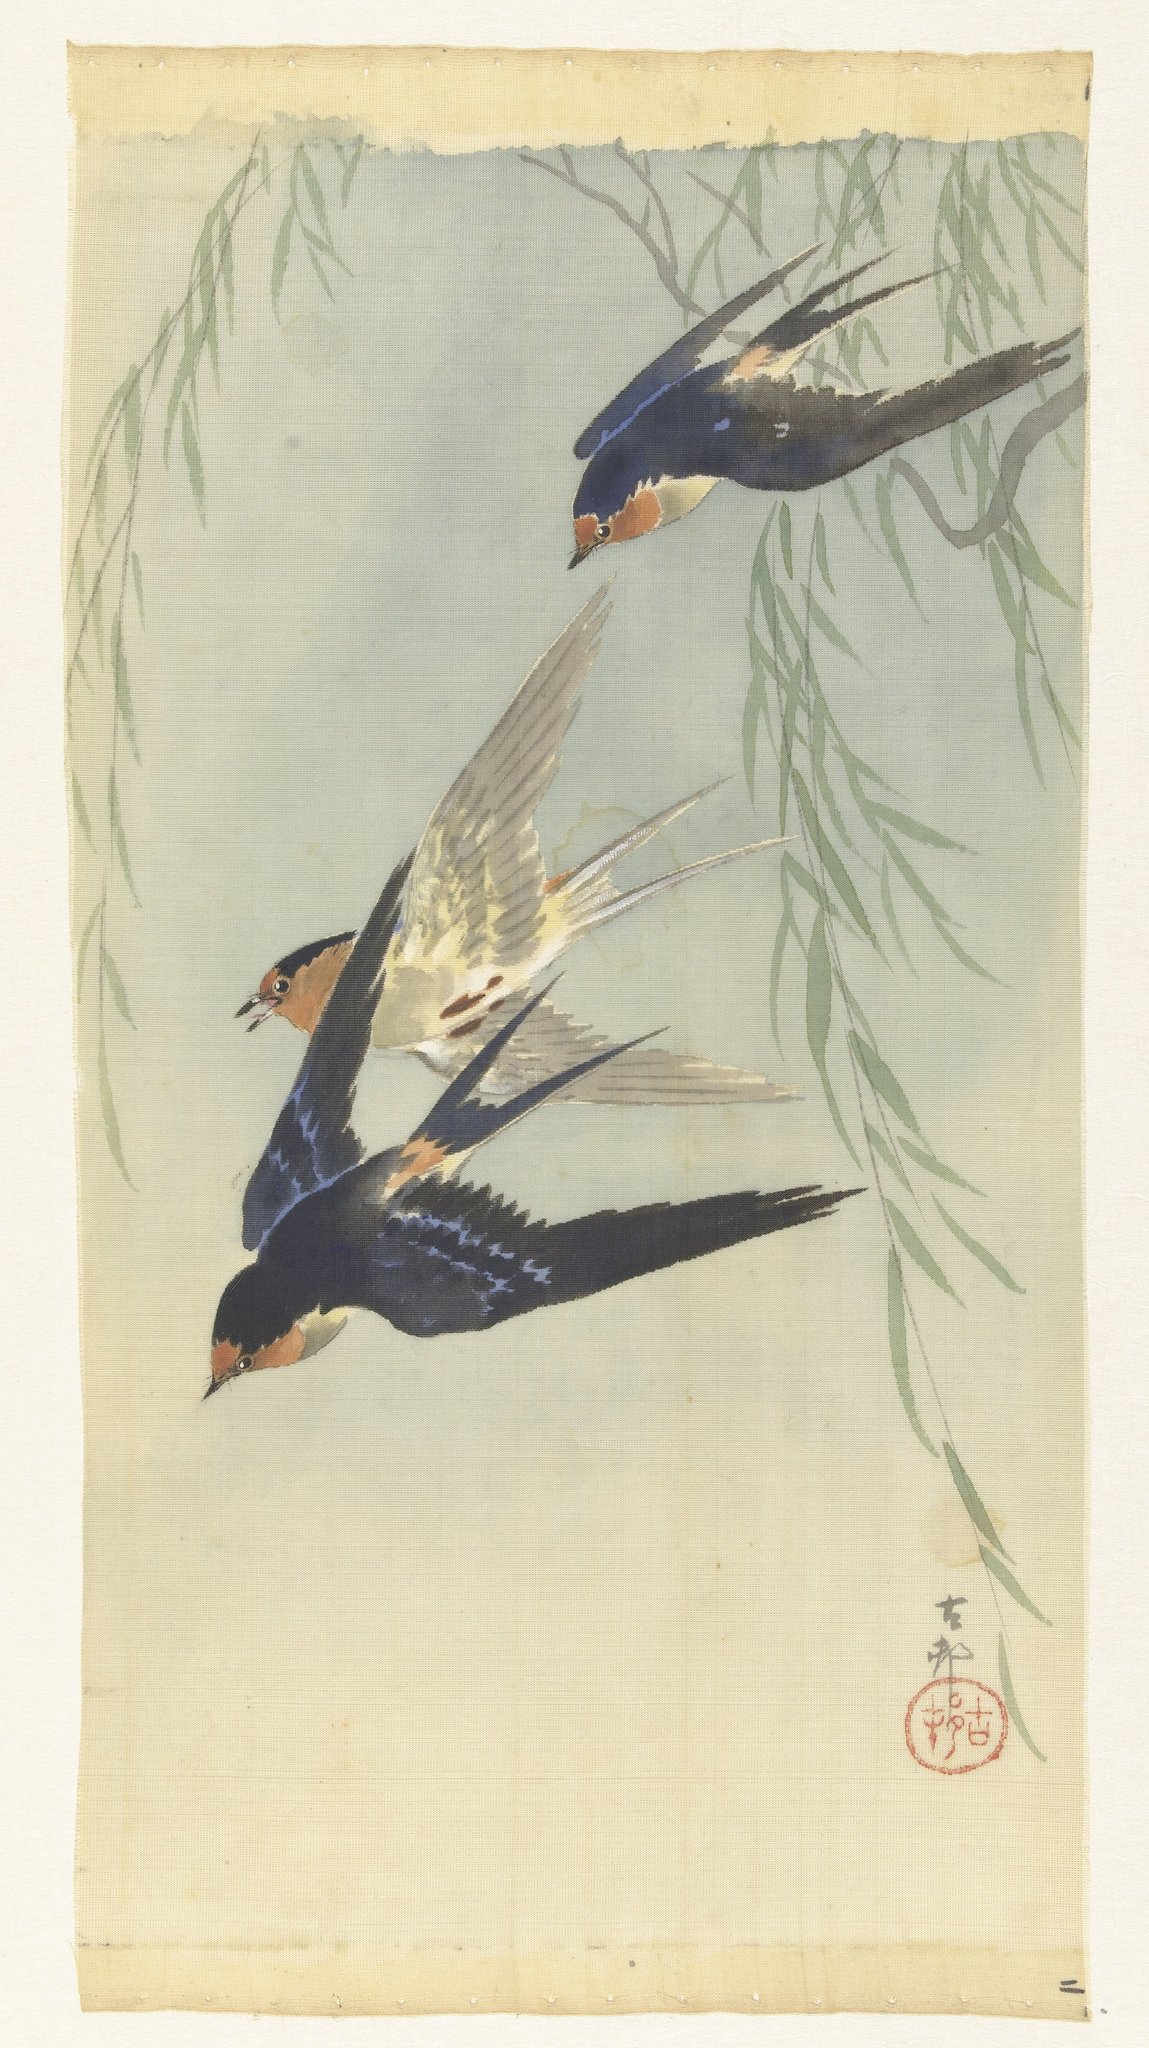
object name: drawing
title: Drie vogels in volle vlucht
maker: ohara koson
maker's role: print maker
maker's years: 1877-1945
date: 1887-1945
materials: paper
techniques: brush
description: Drie vogels in volle vlucht, ontwerptekening voor prent.